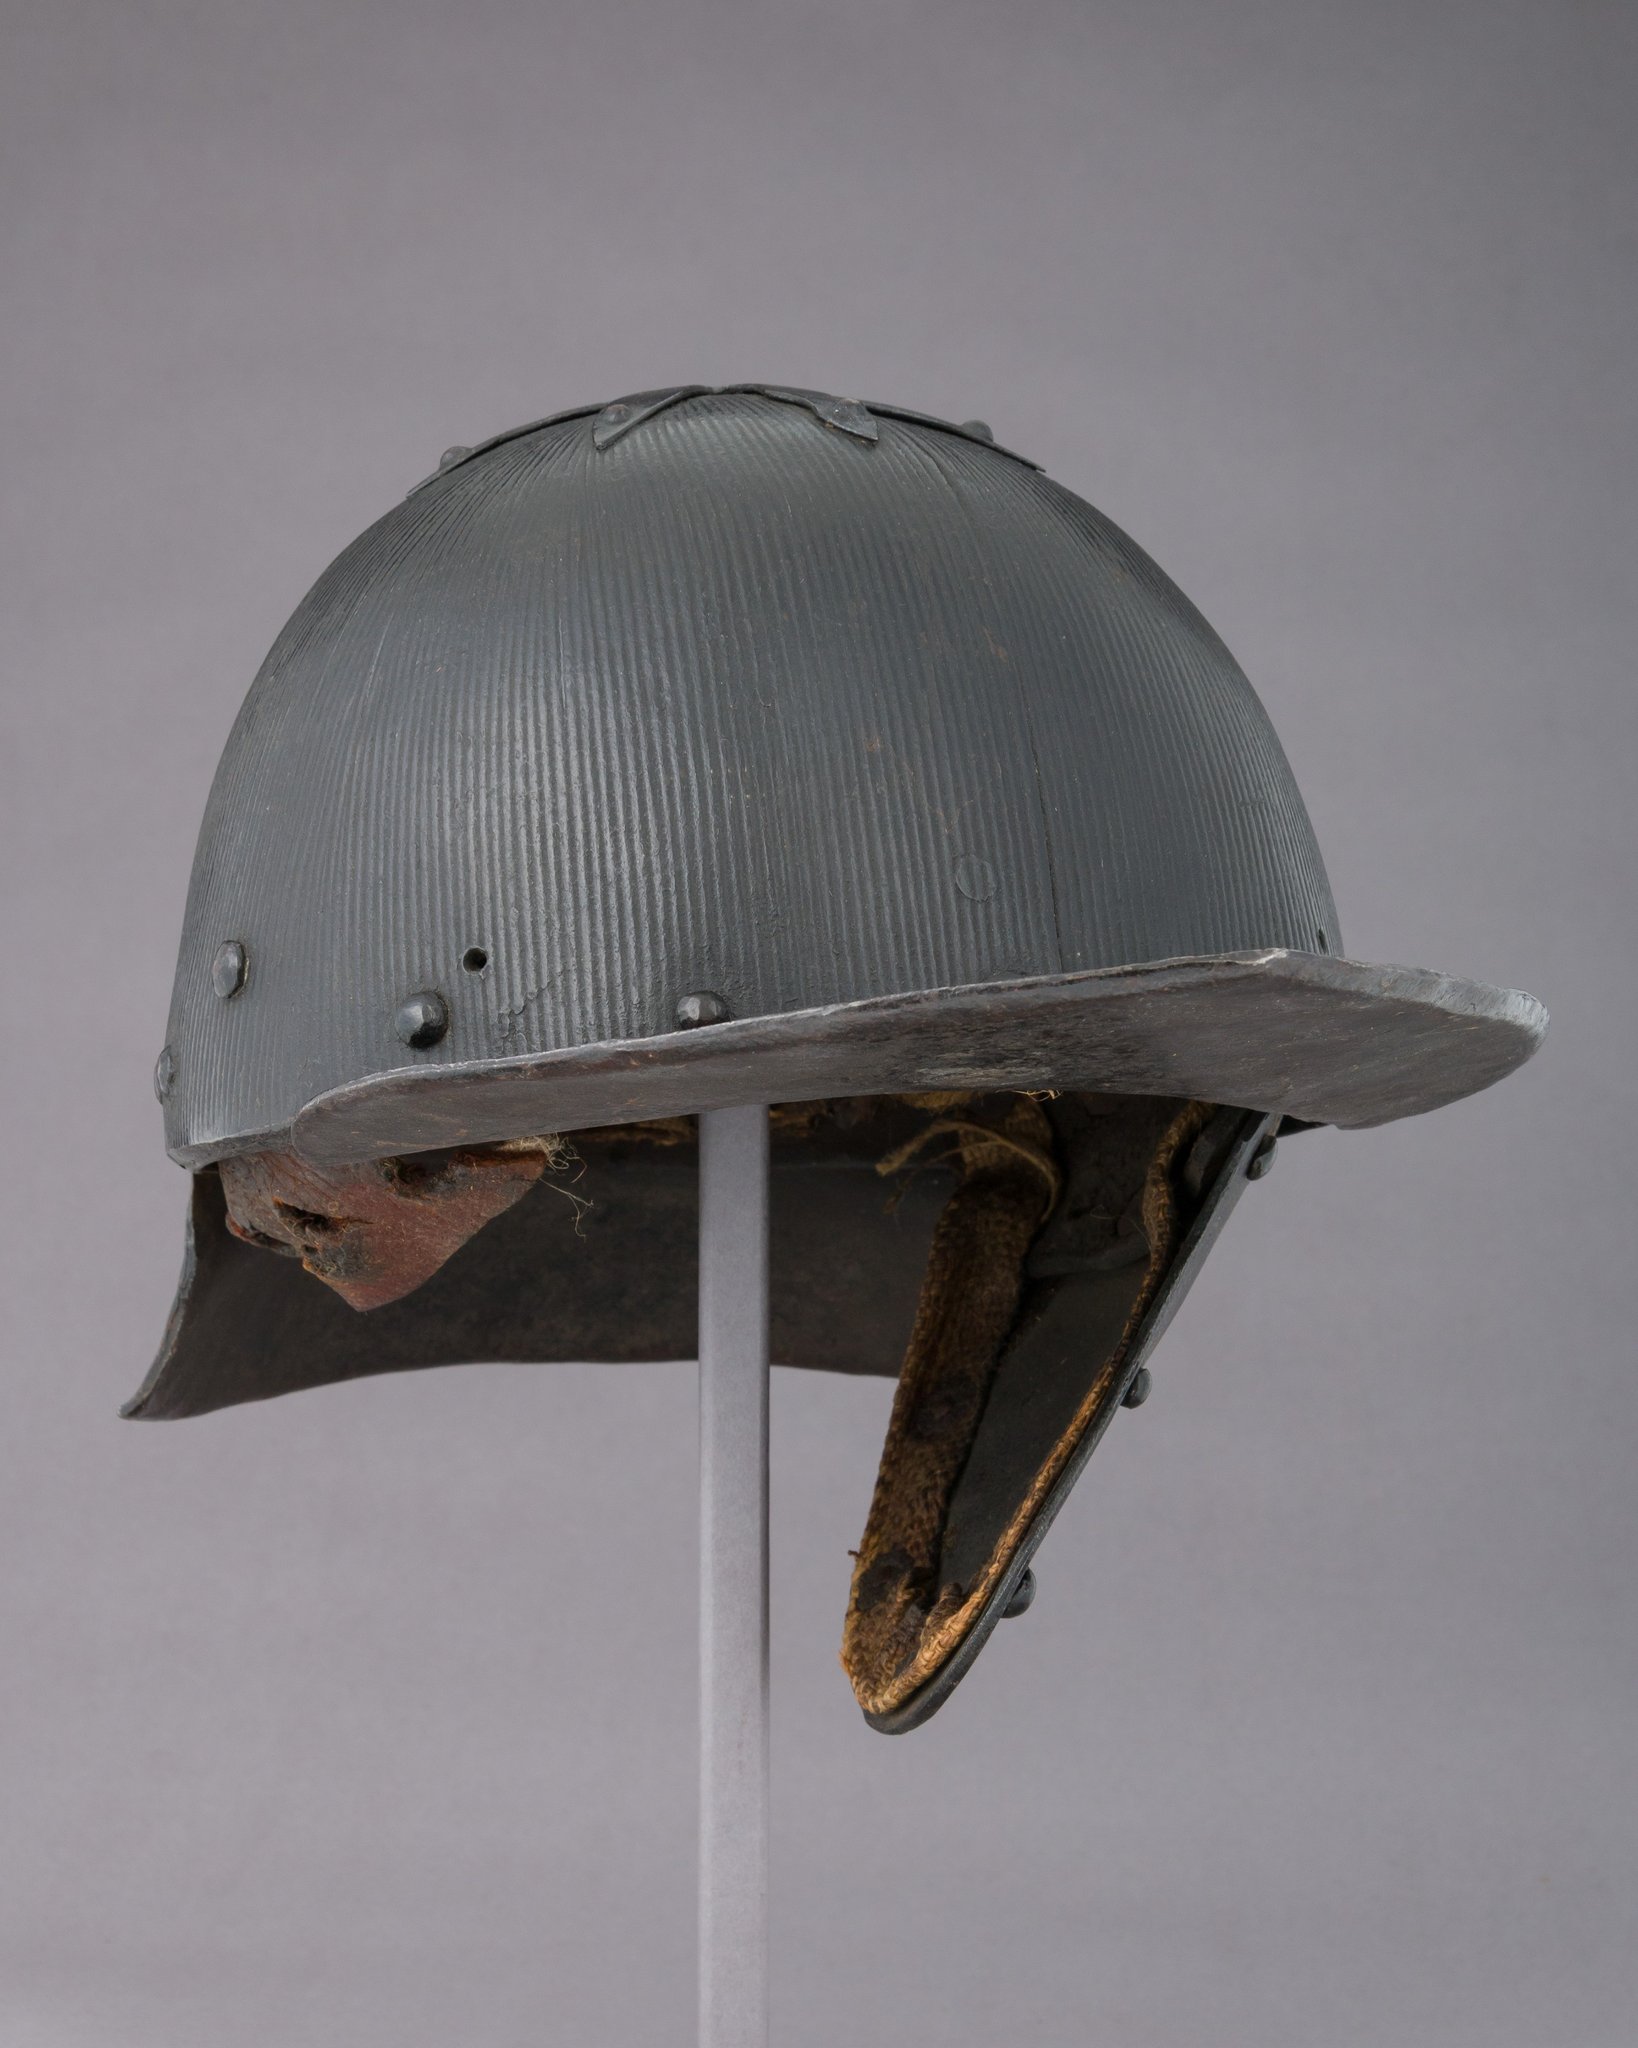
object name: siege helmet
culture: french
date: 1667-1700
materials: leather, steel, textile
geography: france